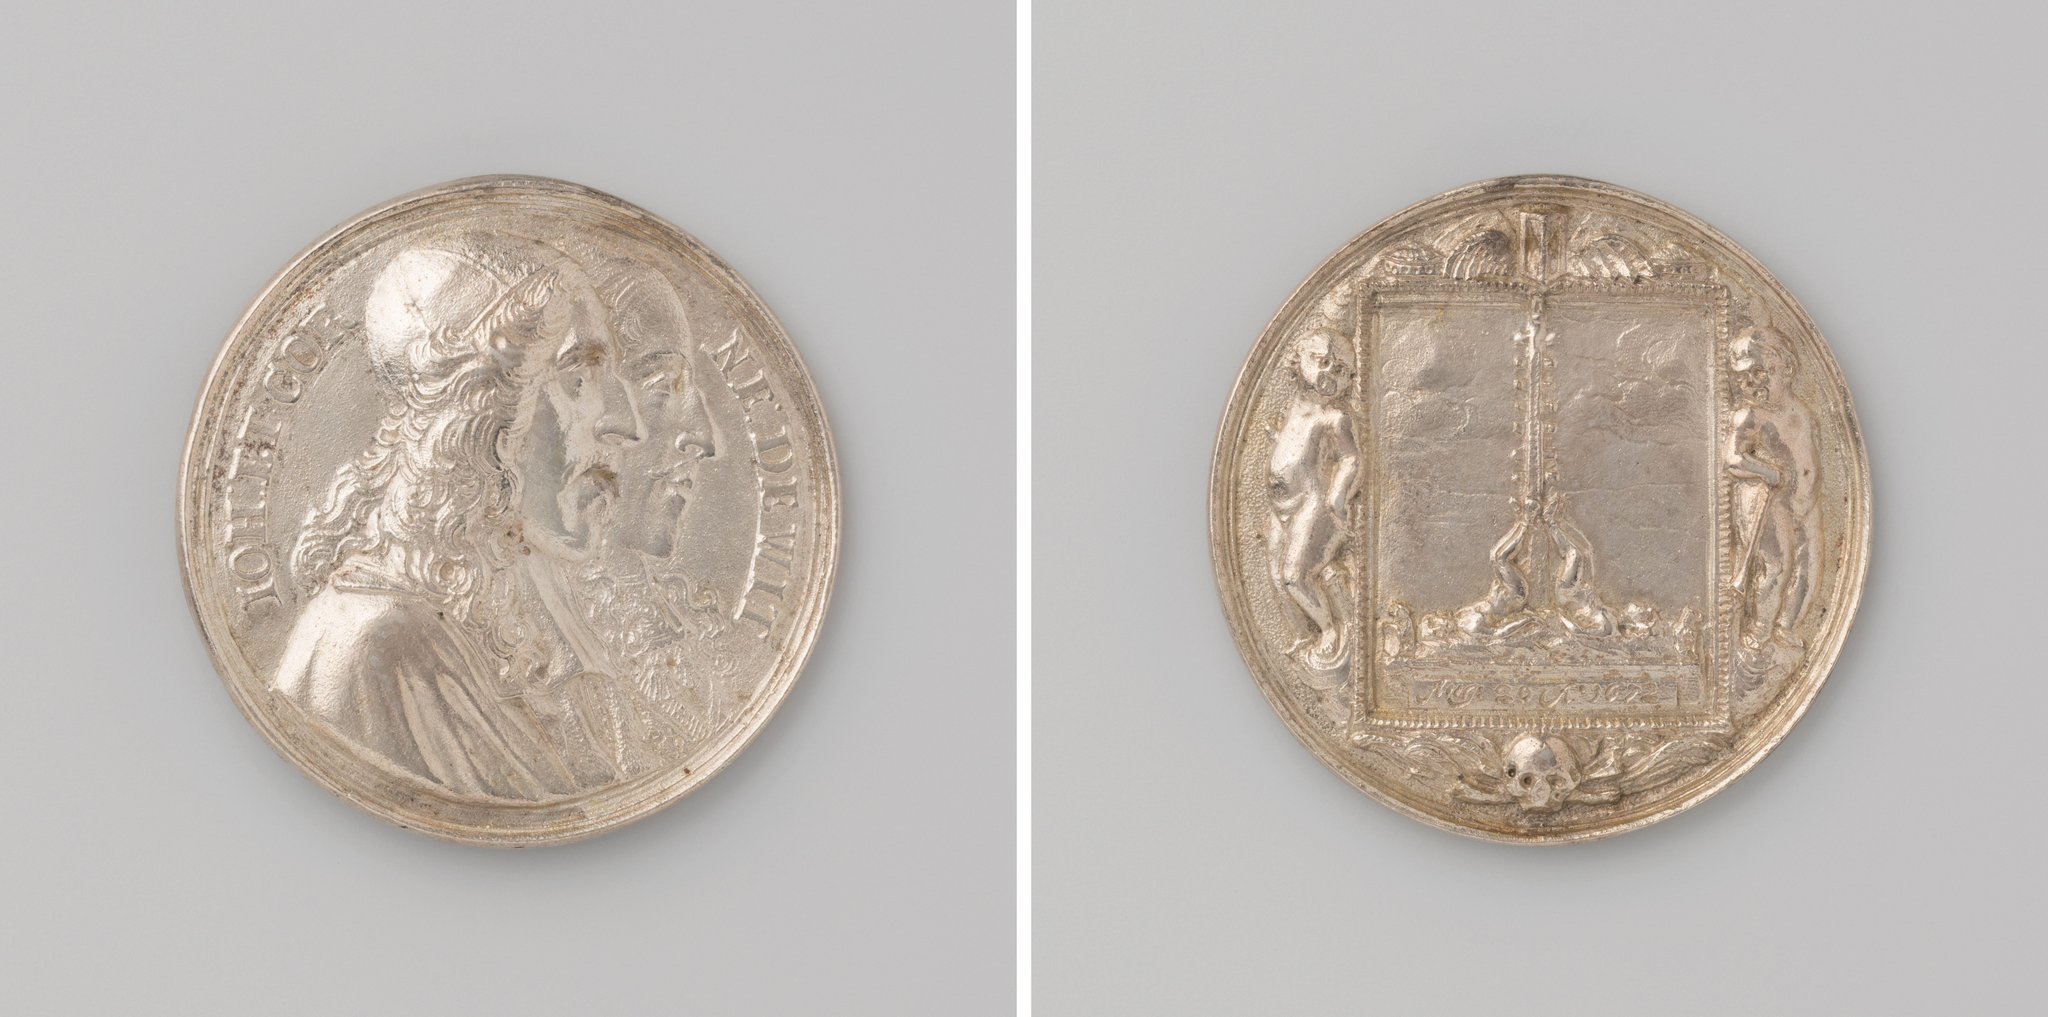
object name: history medal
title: Moord op de gebroeders de Witt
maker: Anonymous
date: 1672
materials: silver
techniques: striking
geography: netherlands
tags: dordrecht, the hague, cornelis de witt, johan de witt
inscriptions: circumscription: ‘IOH.ET CORNE.DE WIT.’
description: Zilveren penning. Voorzijde: borststuk van de gebroeders de Witt binnen omschrift. Keerzijde: lichamen van de gebroeders de Witt omgekeerd opgehangen aan paal afgebeeld op rechthoekig paneel met aan beide zijden naakt jongetje.